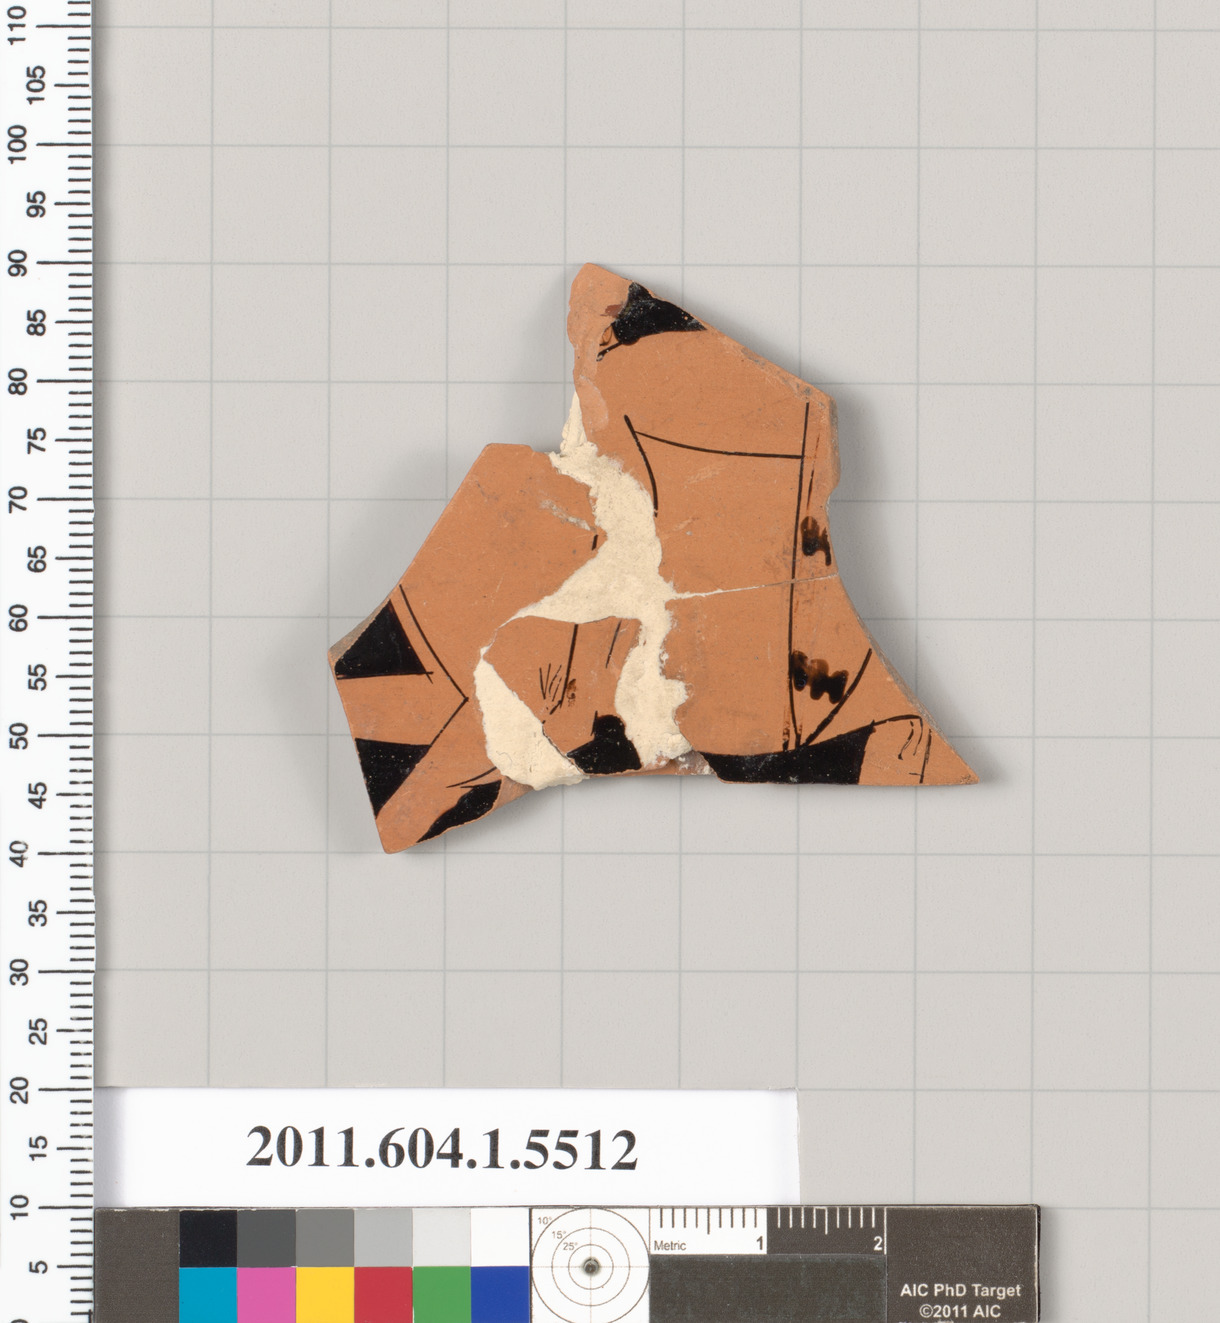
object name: kylix fragment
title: Terracotta fragment of a kylix (drinking cup)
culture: greek, attic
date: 500-490 BCE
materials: terracotta